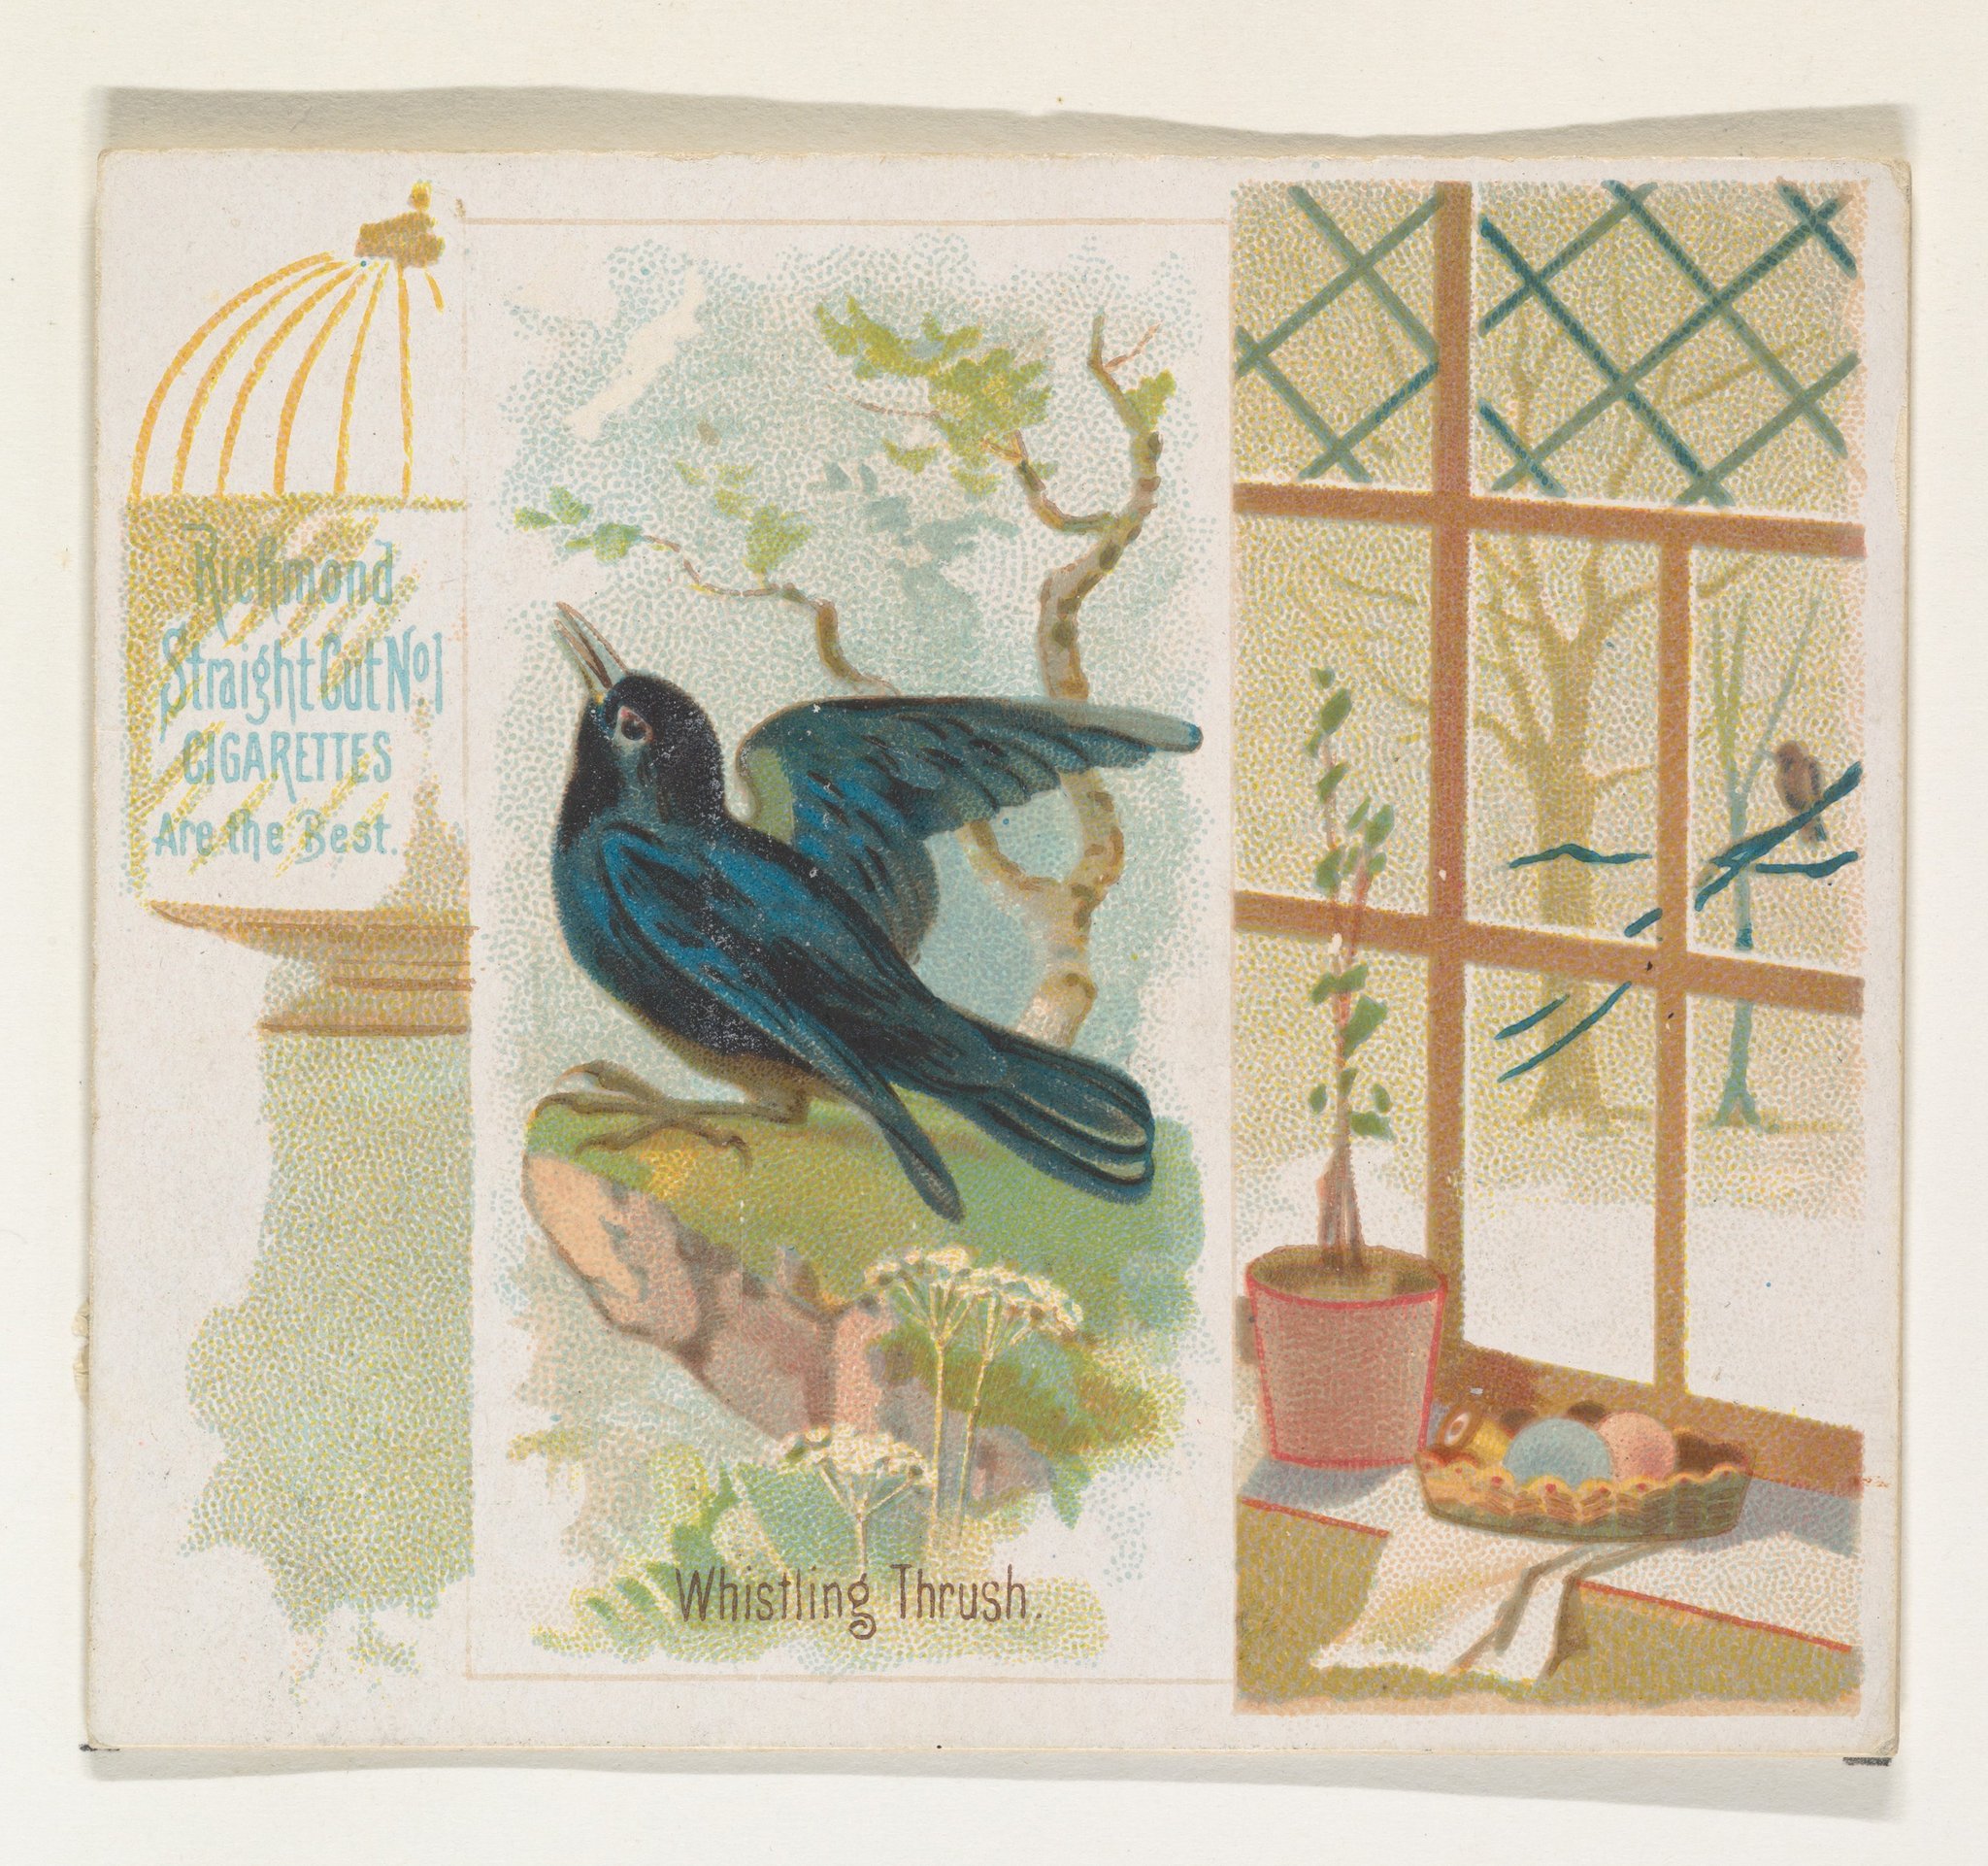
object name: print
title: Whistling Thrush, from the Song Birds of the World series (N42) for Allen & Ginter Cigarettes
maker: allen & ginter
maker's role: publisher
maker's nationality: american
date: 1890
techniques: color lithograph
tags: birds